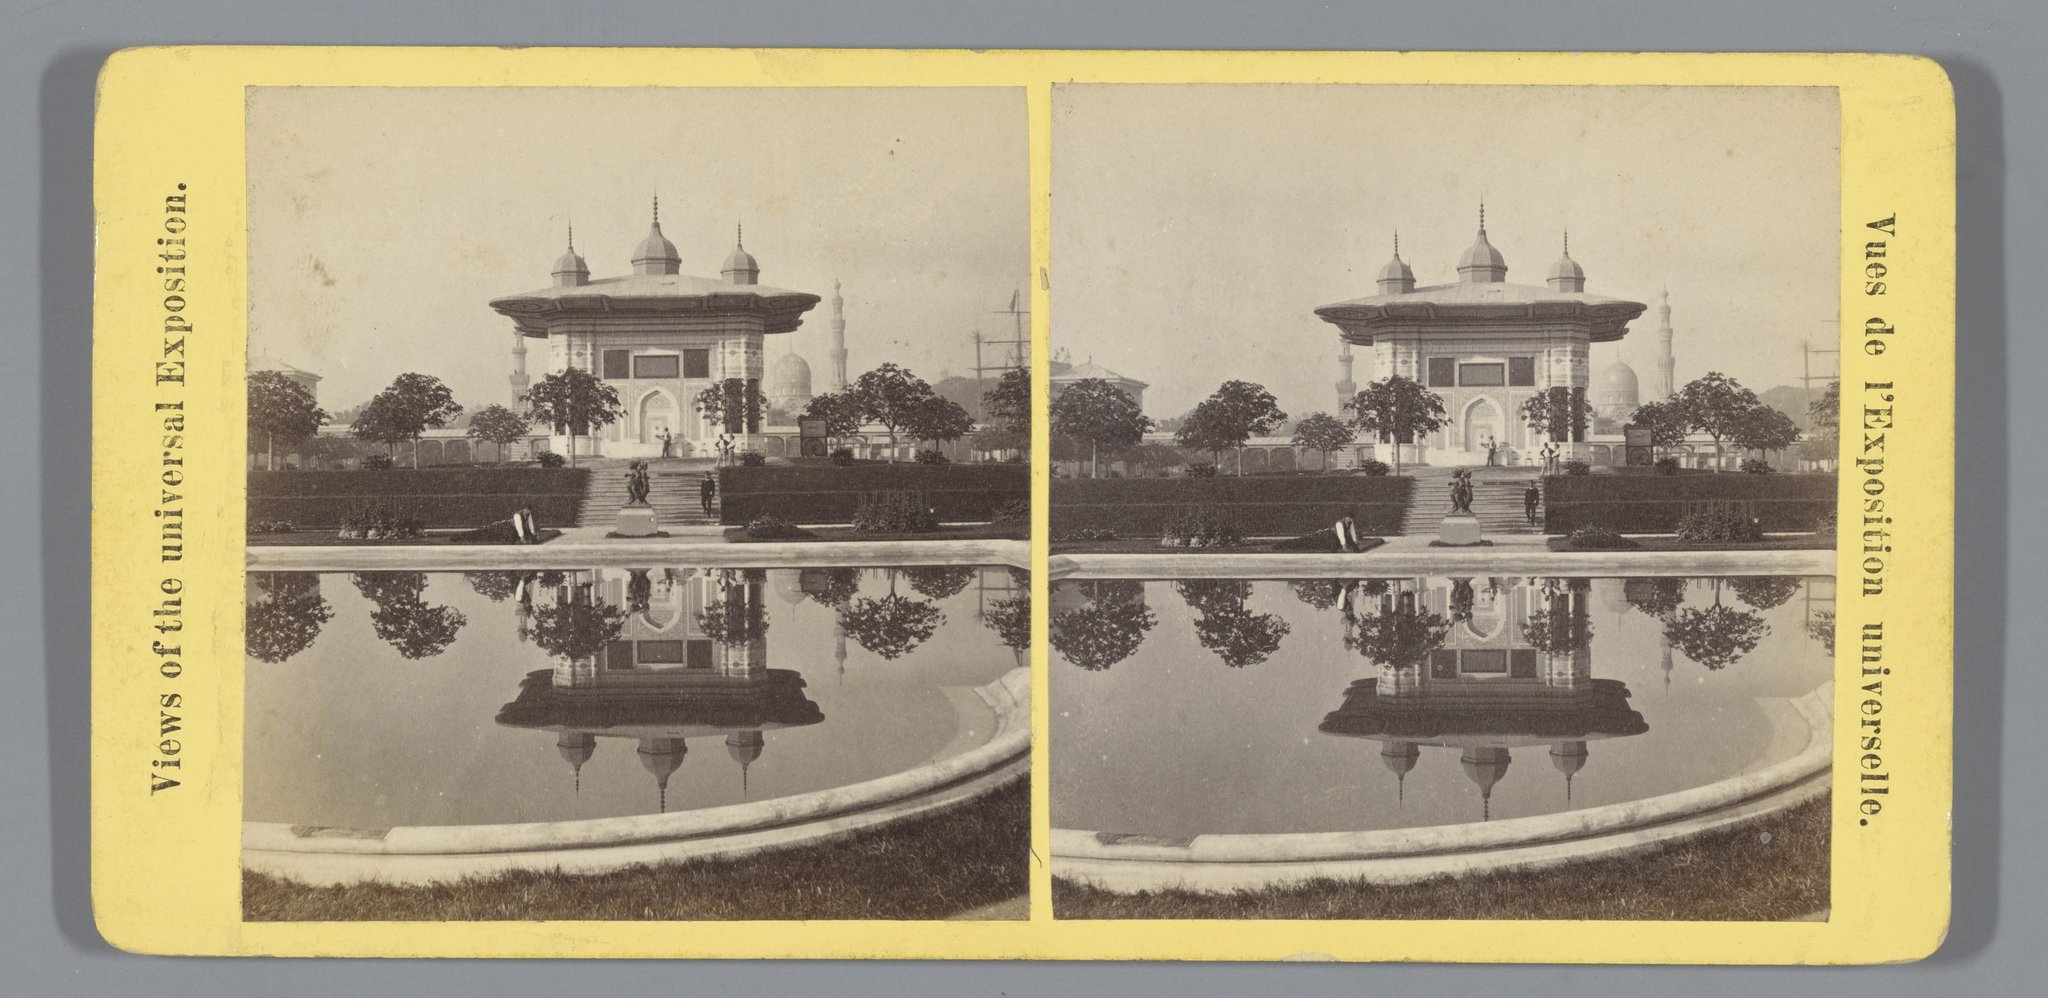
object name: stereograph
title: Views of the universal Exposition / Vues de l'Exposition universelle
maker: Anonymous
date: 1878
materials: cardboard, paper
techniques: albumen print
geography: paris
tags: world fair, world exhibition, paris